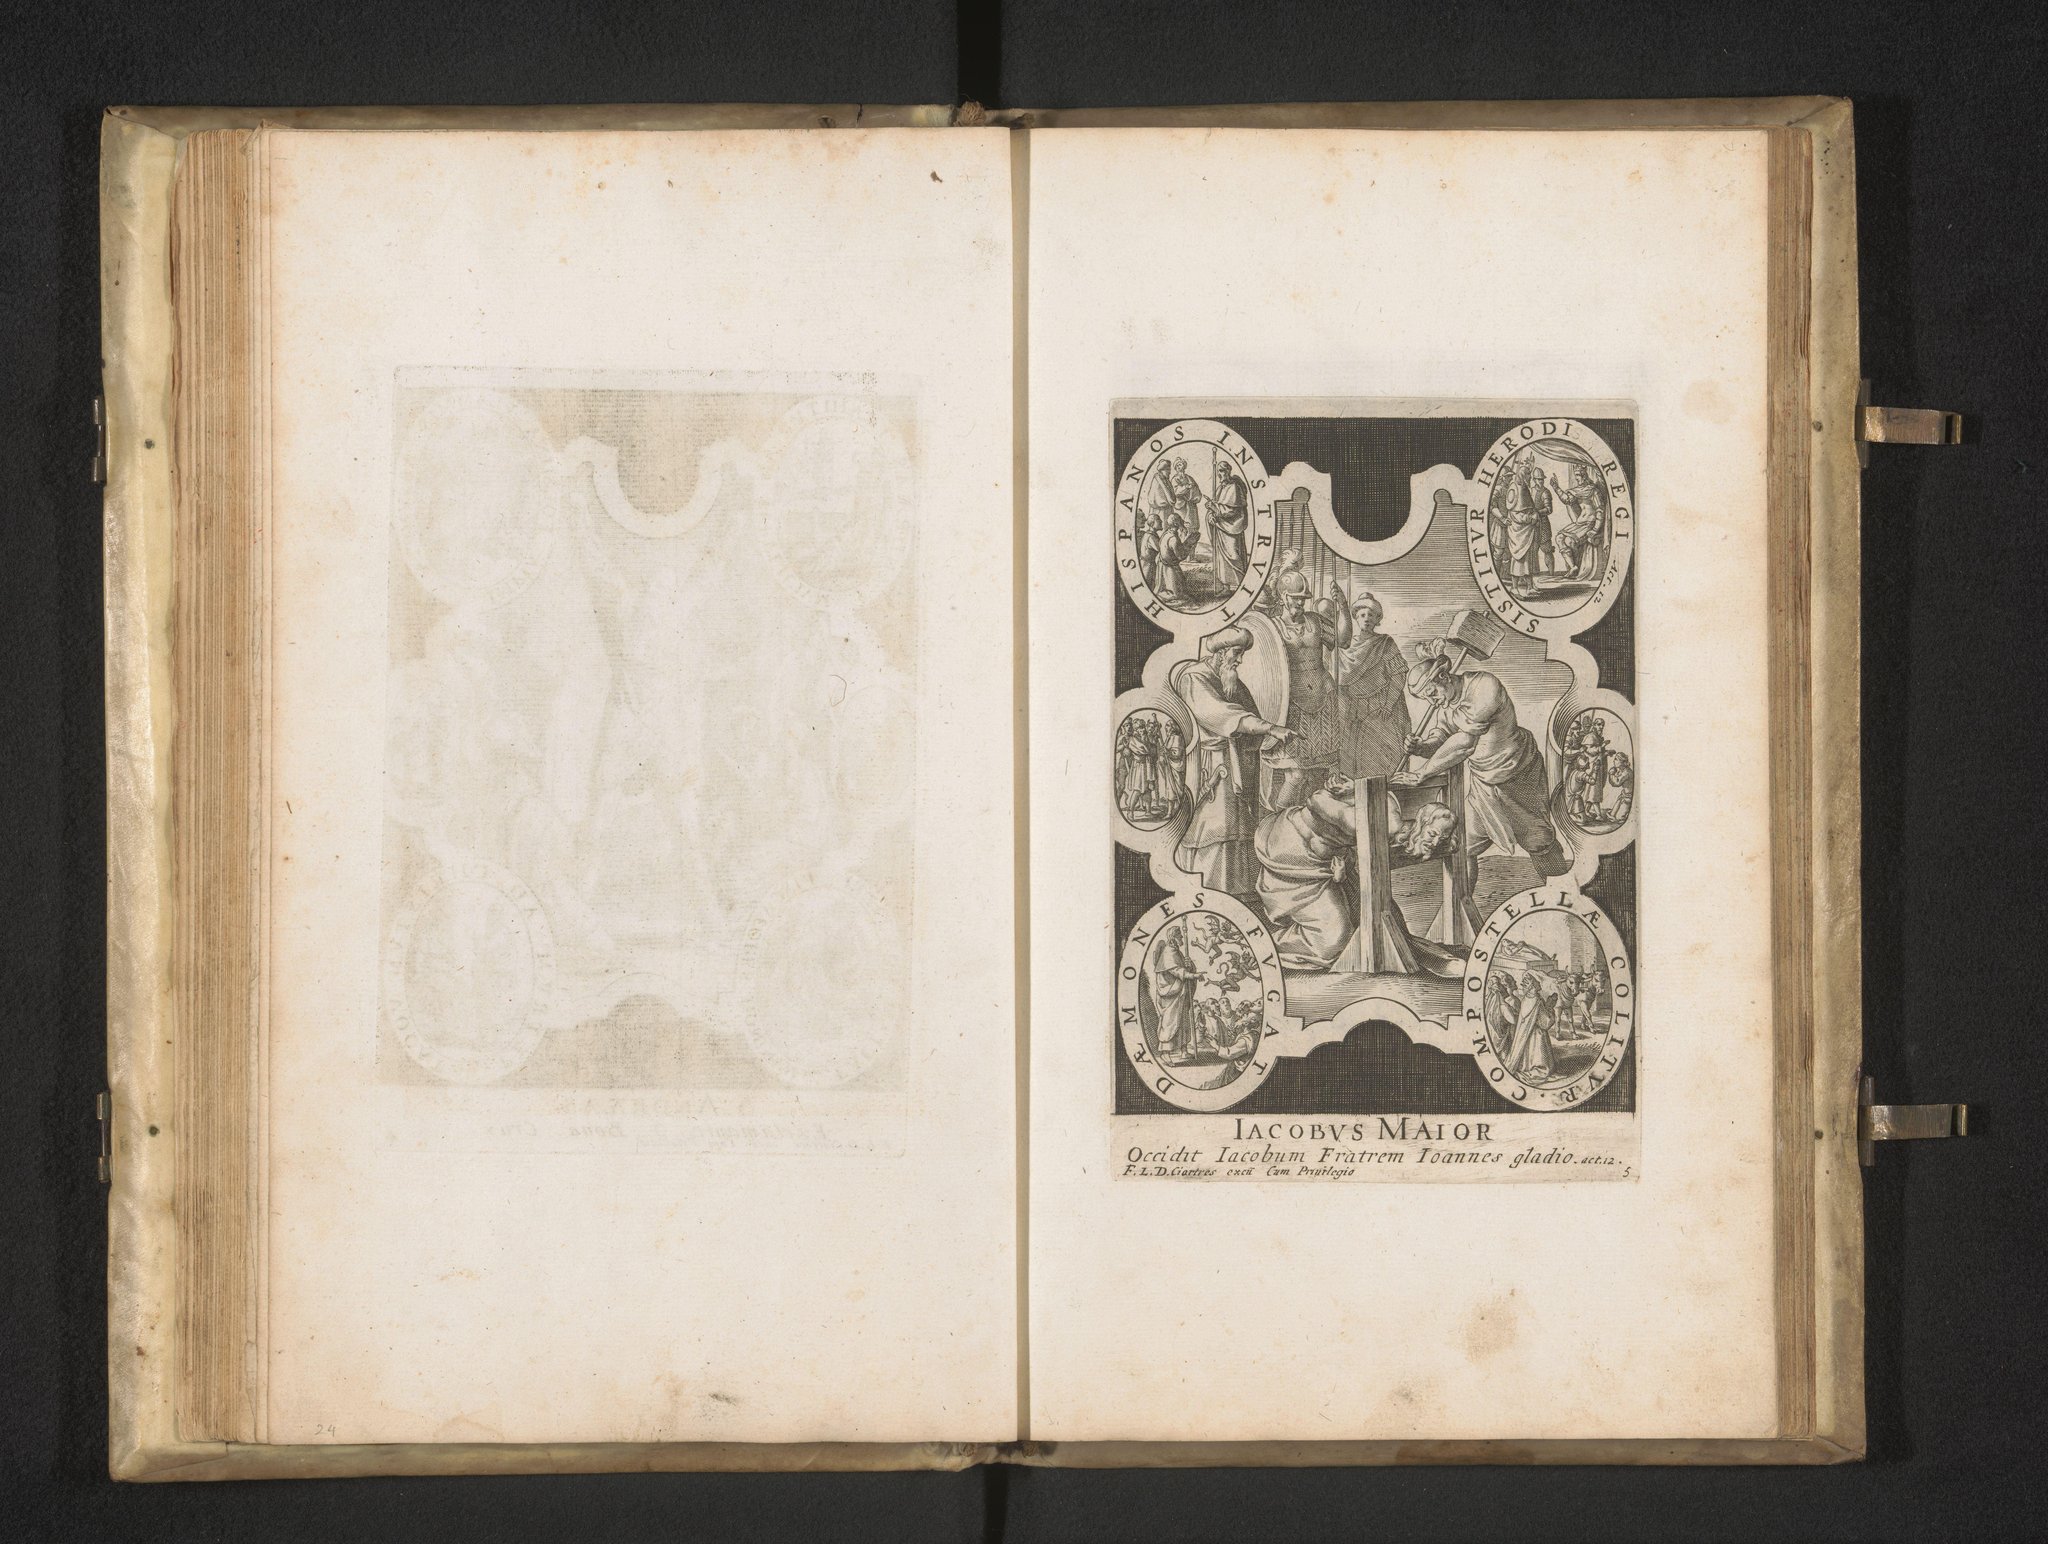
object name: print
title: Iacobus Maior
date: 1610-1647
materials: paper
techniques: engraving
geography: paris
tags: beheading of james, the apostle james the great; possible attributes: book, pilgrim's cloak, hat, shell, staff, and wallet, scroll, sword - martyrdom, suffering, misfortune, death of male saint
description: Martelaarschap van Jakobus de Meerdere, in een kader met zes kleine scènes uit zijn leven. Onderdeel van een serie van twaalf voorstellingen van het martelaarschap van de apostelen. Onderdeel van een album met voornamelijk christelijke voorstellingen.